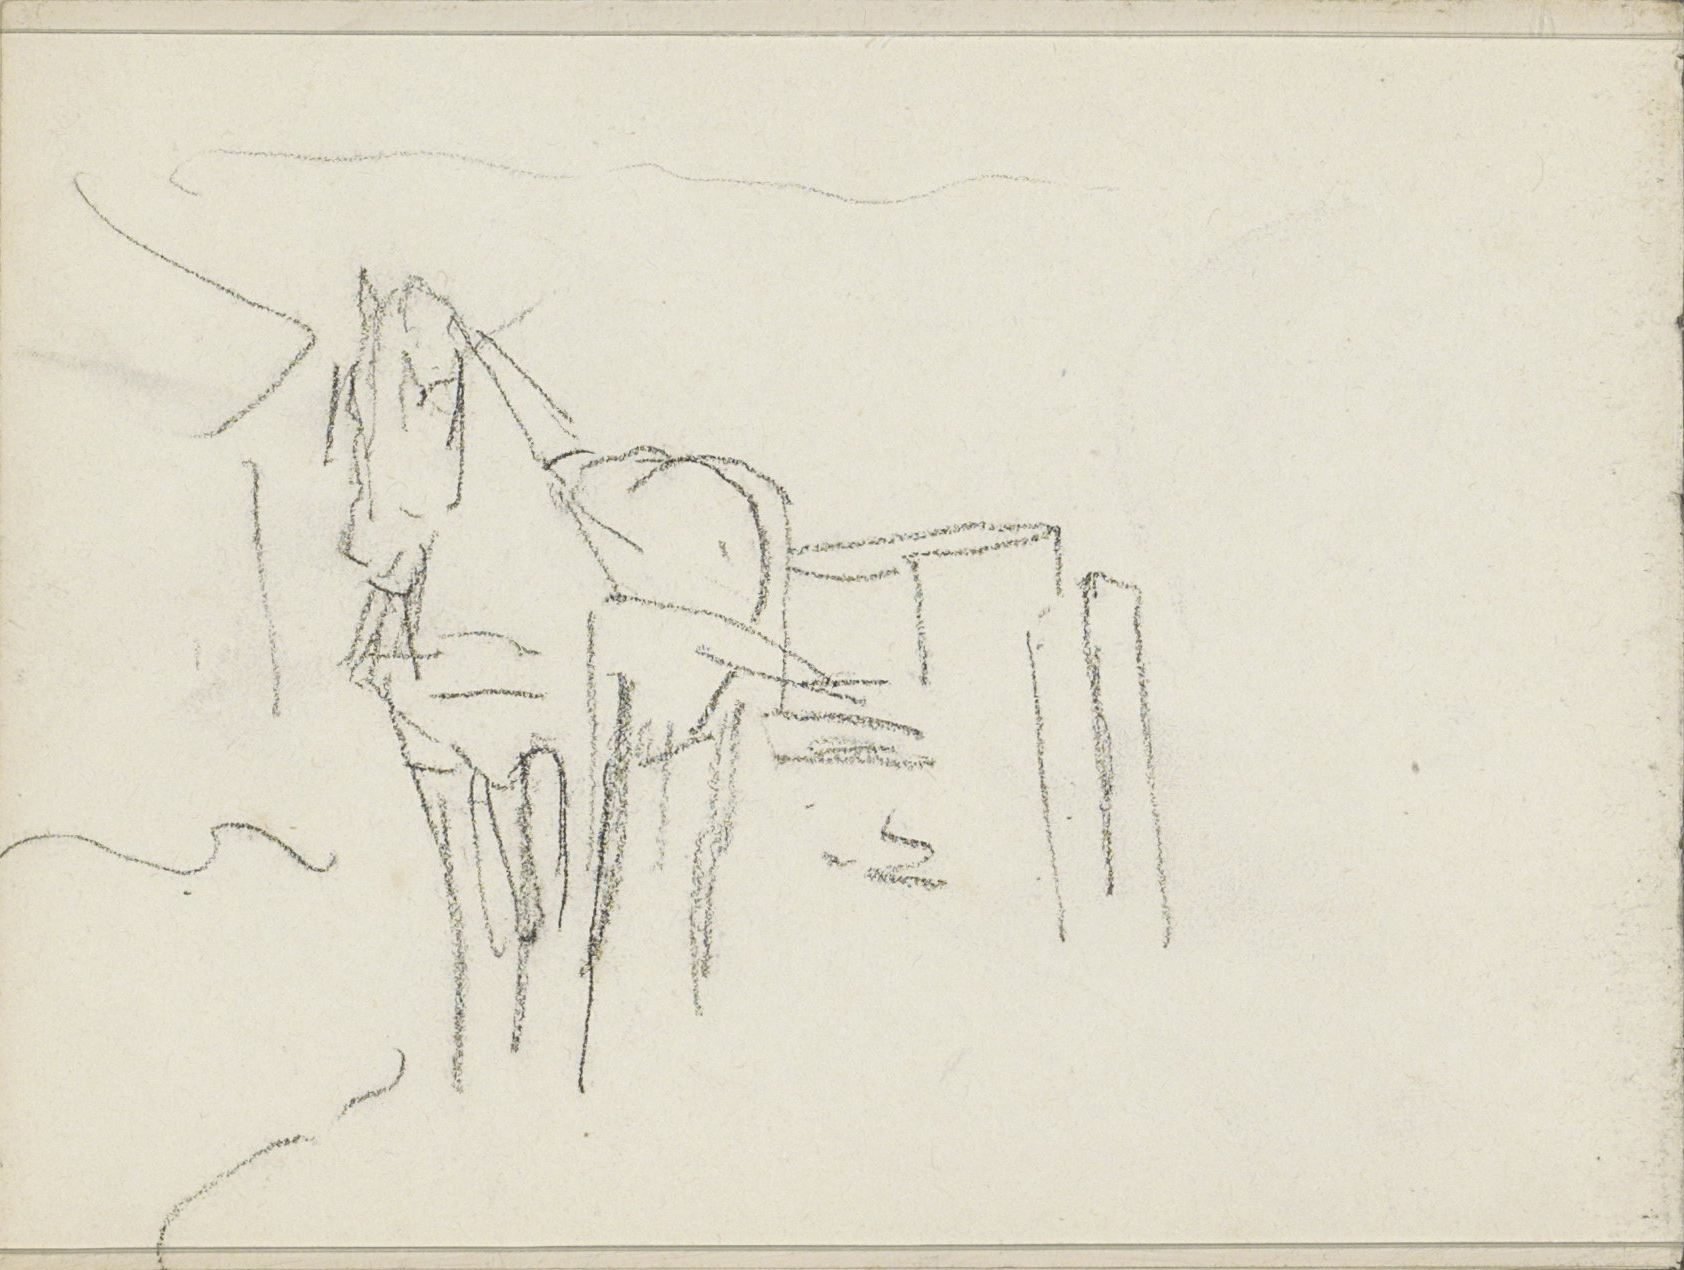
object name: sketchbook leaf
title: Voor een kar gespannen paard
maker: anton mauve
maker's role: draughtsman, painter, print maker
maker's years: 1838-1888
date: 1881-1888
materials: chalk, paper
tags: animal traction, animal-drawn vehicle (carriage etc.), horse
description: Blad 25 verso uit een schetsboek met 29 bladen.